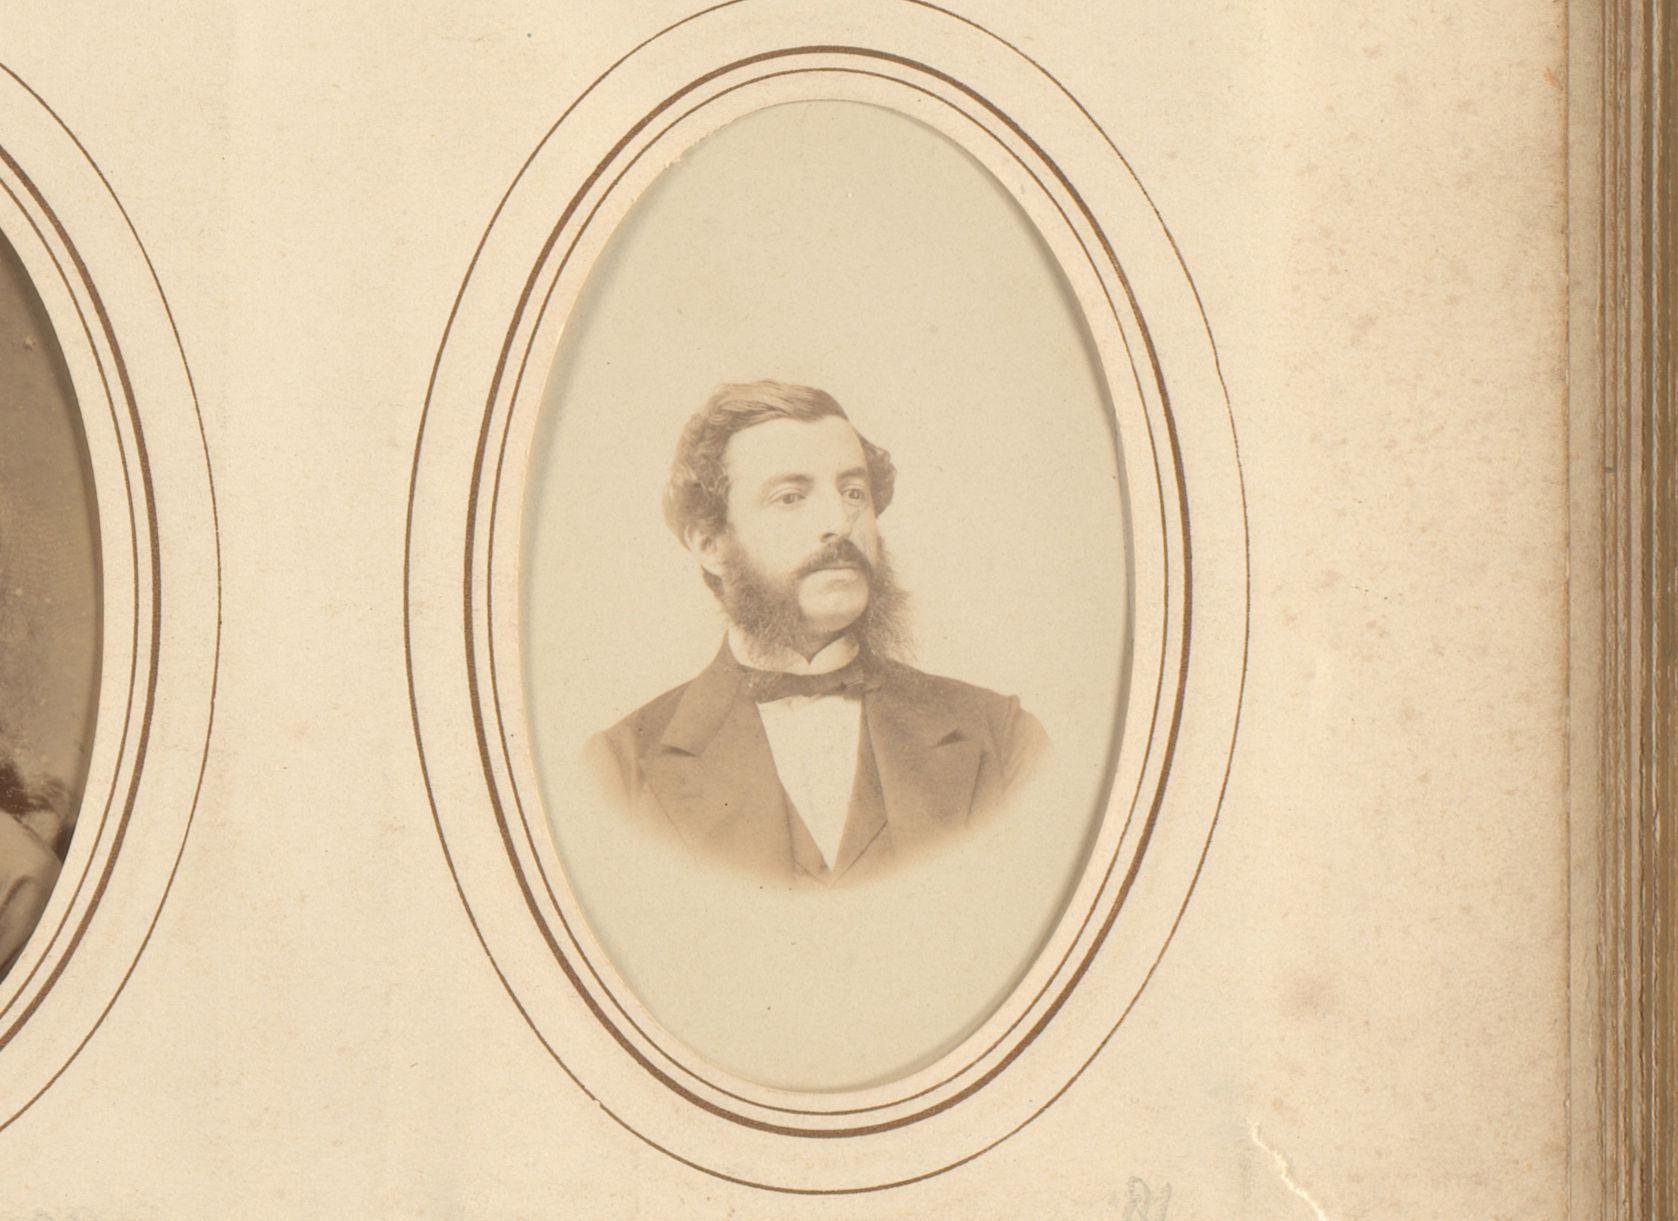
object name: carte de visite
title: Portret van een man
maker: joseph dupont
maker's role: fotograaf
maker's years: 1818-1901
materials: cardboard, photographic support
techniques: albumen print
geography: brussels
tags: adult man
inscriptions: annotation: ‘Au cher camarade Duquesne / Souvenir affectueux des heureux moments / passés avec lui à Utrecht en mai 1874 et Bruxelles septembre 1874 / [...]’, inscription: ‘Dupont Phot. Bruxelles’, inscription: ‘DUPONT / BRUXELLES / 67, Rue Neuve, 67.’